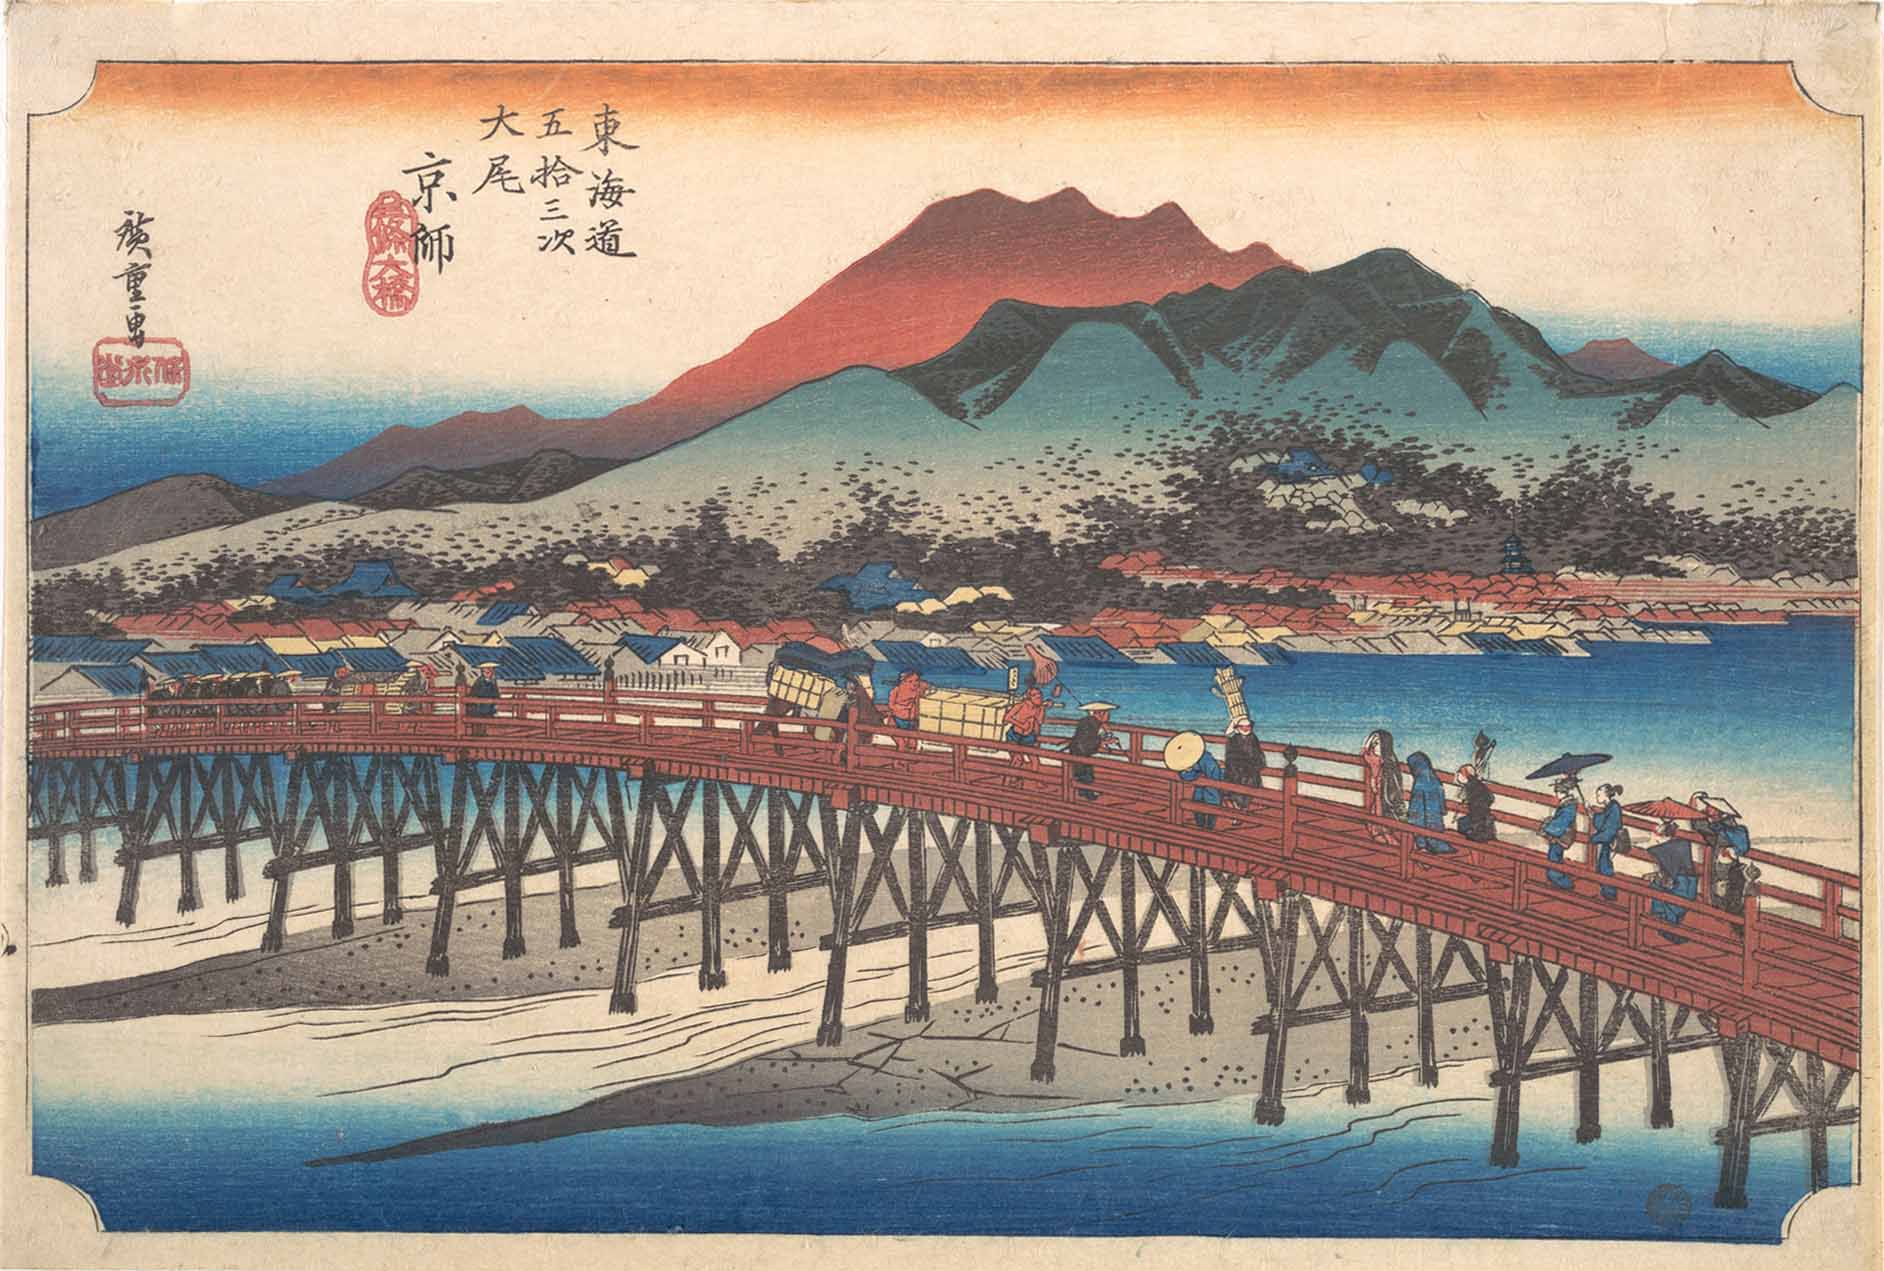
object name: print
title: Kyoto: The Great Bridge at Sanjō (Taibi, Keishi, Sanjō Ōhashi), from the series Fifty-Three Stations of the Tōkaidō (Tōkaidō gojūsan tsugi)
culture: japanese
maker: utagawa hiroshige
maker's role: artist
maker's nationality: japanese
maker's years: 1797-1858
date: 1833-1834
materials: ink, paper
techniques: woodblock print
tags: human figures,bridges,rivers,mountains